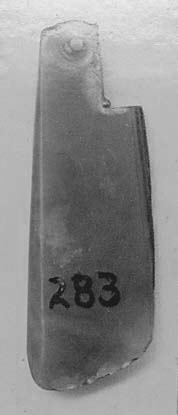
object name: knife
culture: asian or american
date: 1902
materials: jade